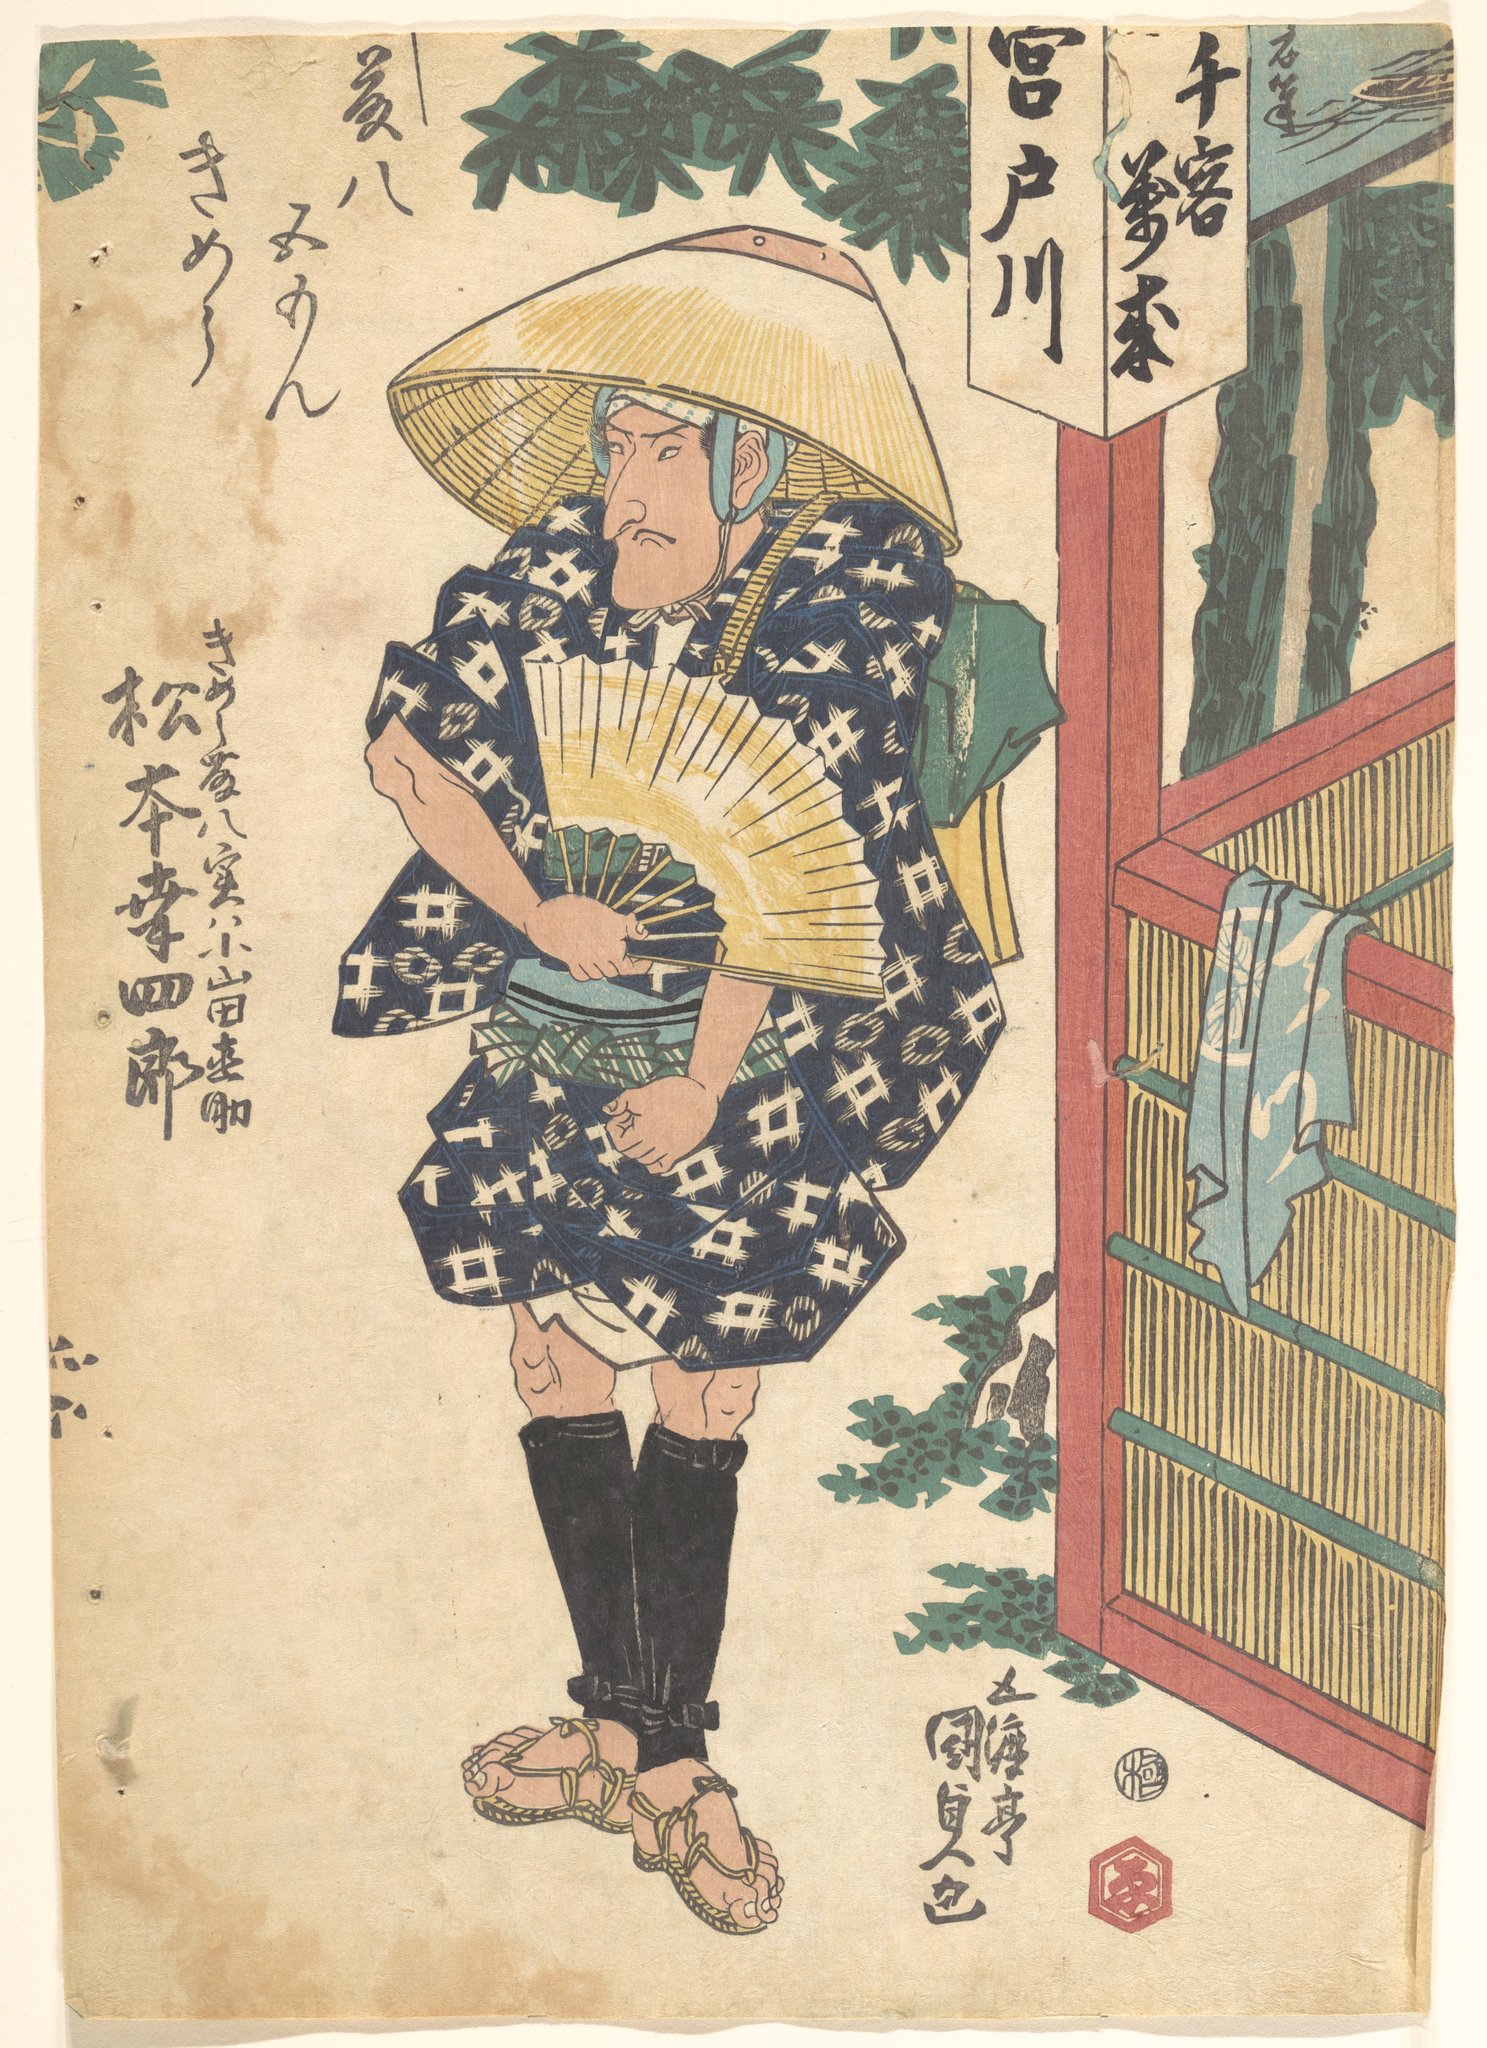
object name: print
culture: japanese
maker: utagawa kunisada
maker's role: artist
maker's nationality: japanese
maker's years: 1786-1864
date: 1801-1900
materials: ink, paper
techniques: woodblock print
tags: fans,men